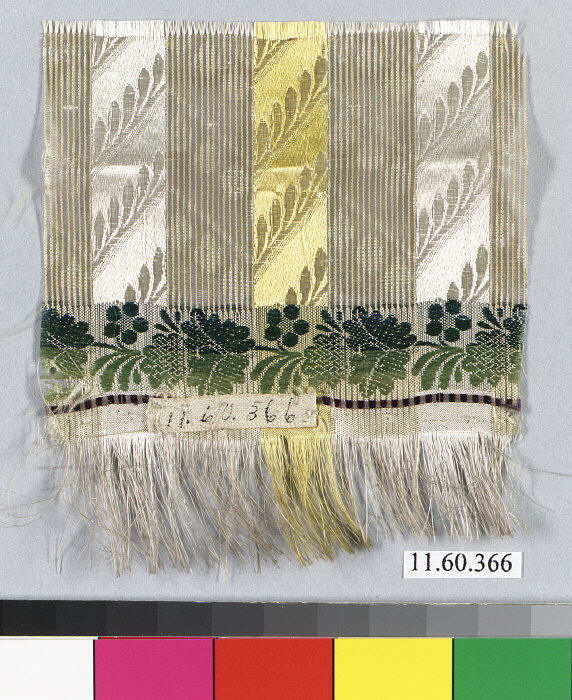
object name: fragment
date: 1801-1900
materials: silk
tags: flowers,leaves